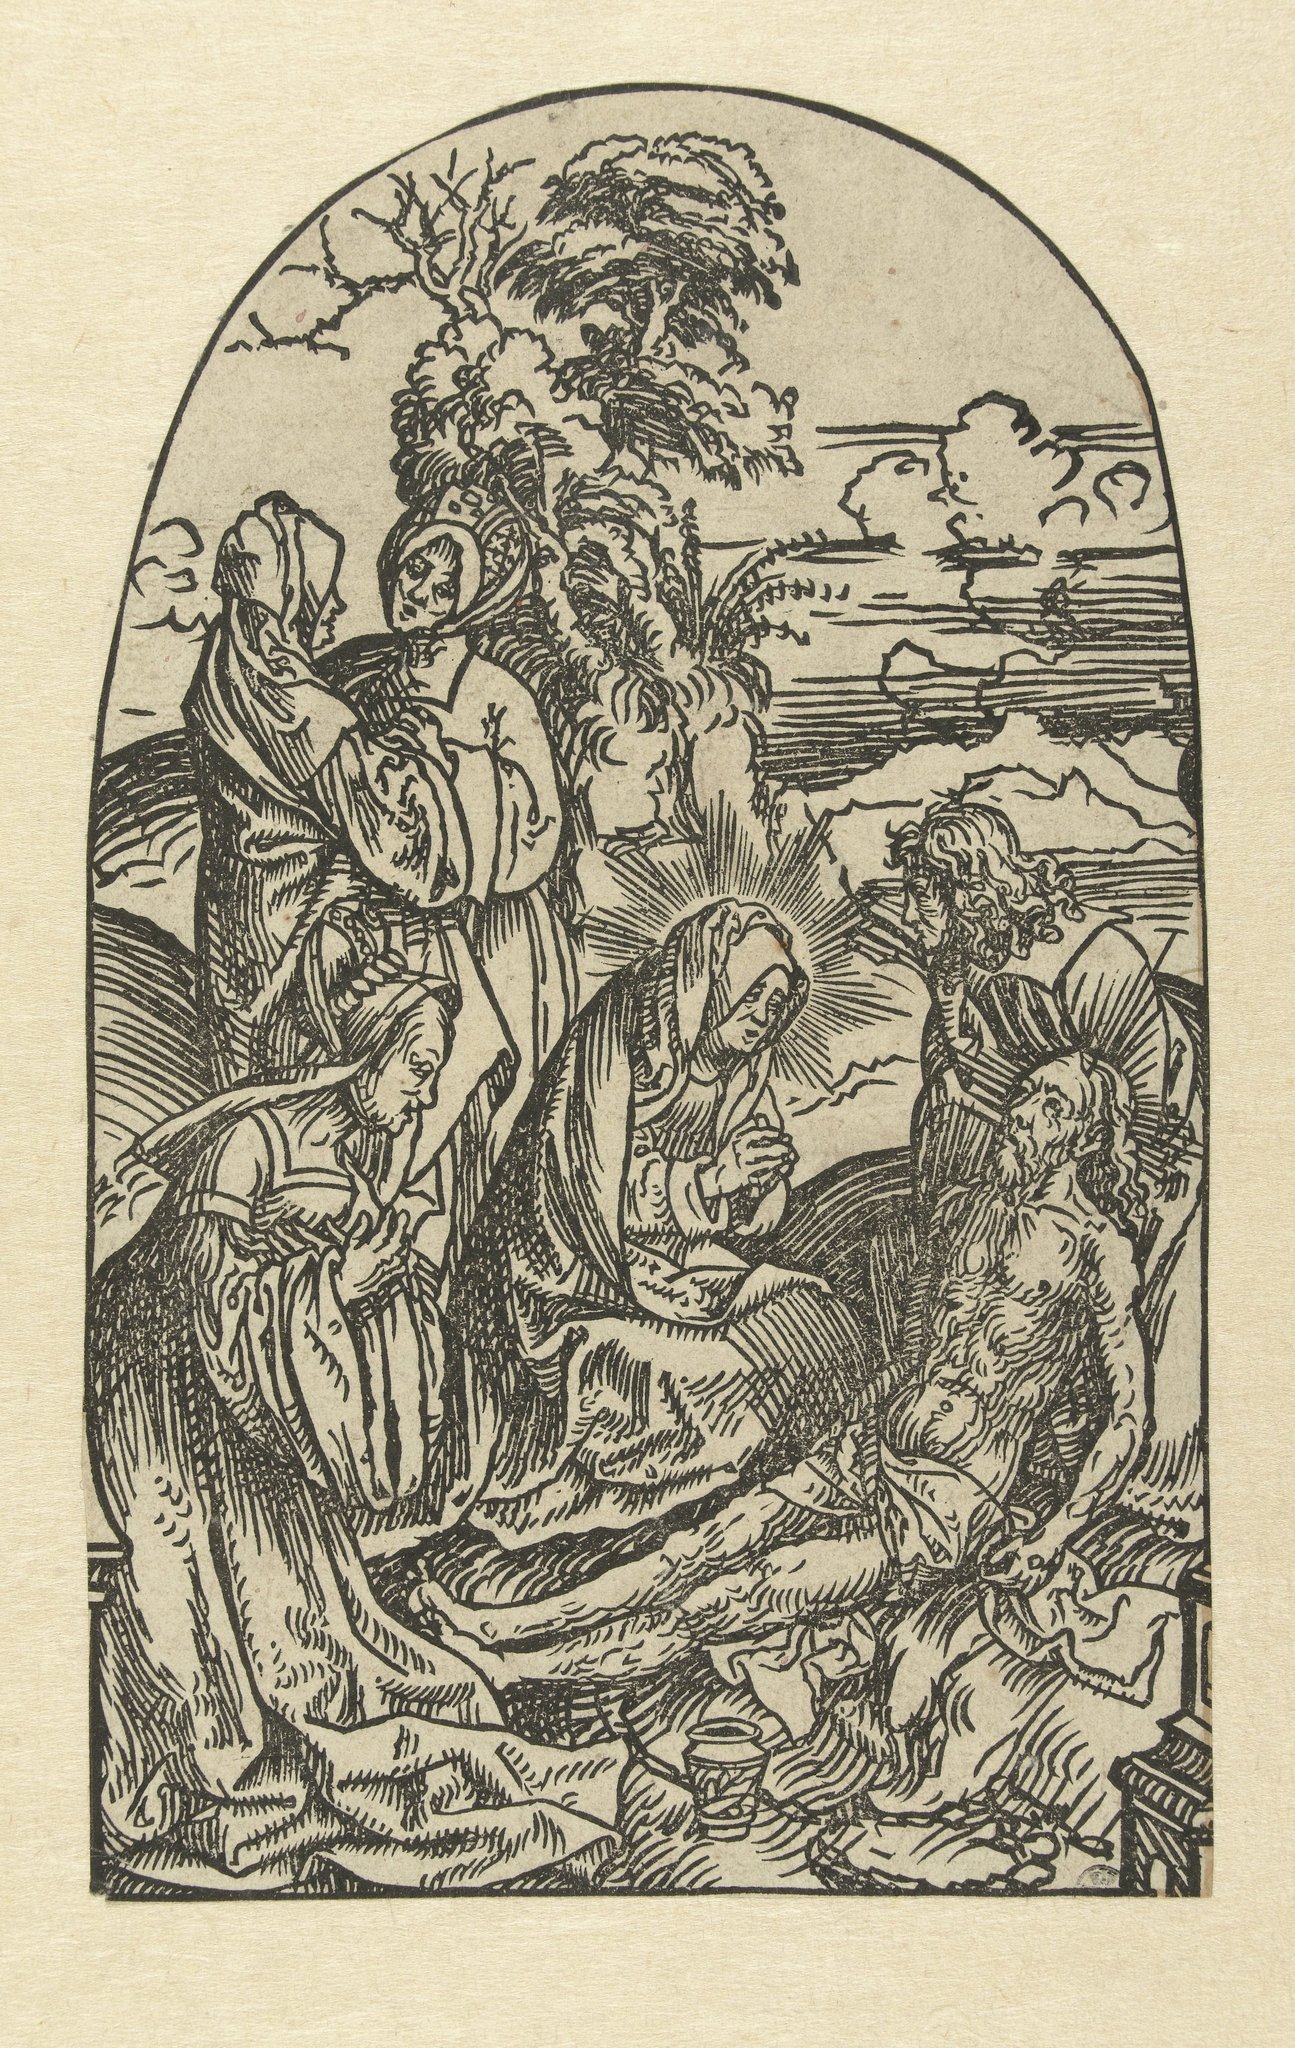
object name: print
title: Bewening van Christus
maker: jacob cornelisz van oostsanen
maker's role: draughtsman, painter, print maker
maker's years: 1475-1533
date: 1507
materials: paper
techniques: woodcut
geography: low countries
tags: lamentation over the dead christ by his relatives and friends (christ usually without crown of thorns)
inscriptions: collector's mark: Lugt 2228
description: Fragment van een prent met vier voorstellingen, uit een serie van zeven. Dode Christus beweend door Maria, Johannes en de drie Maria's.